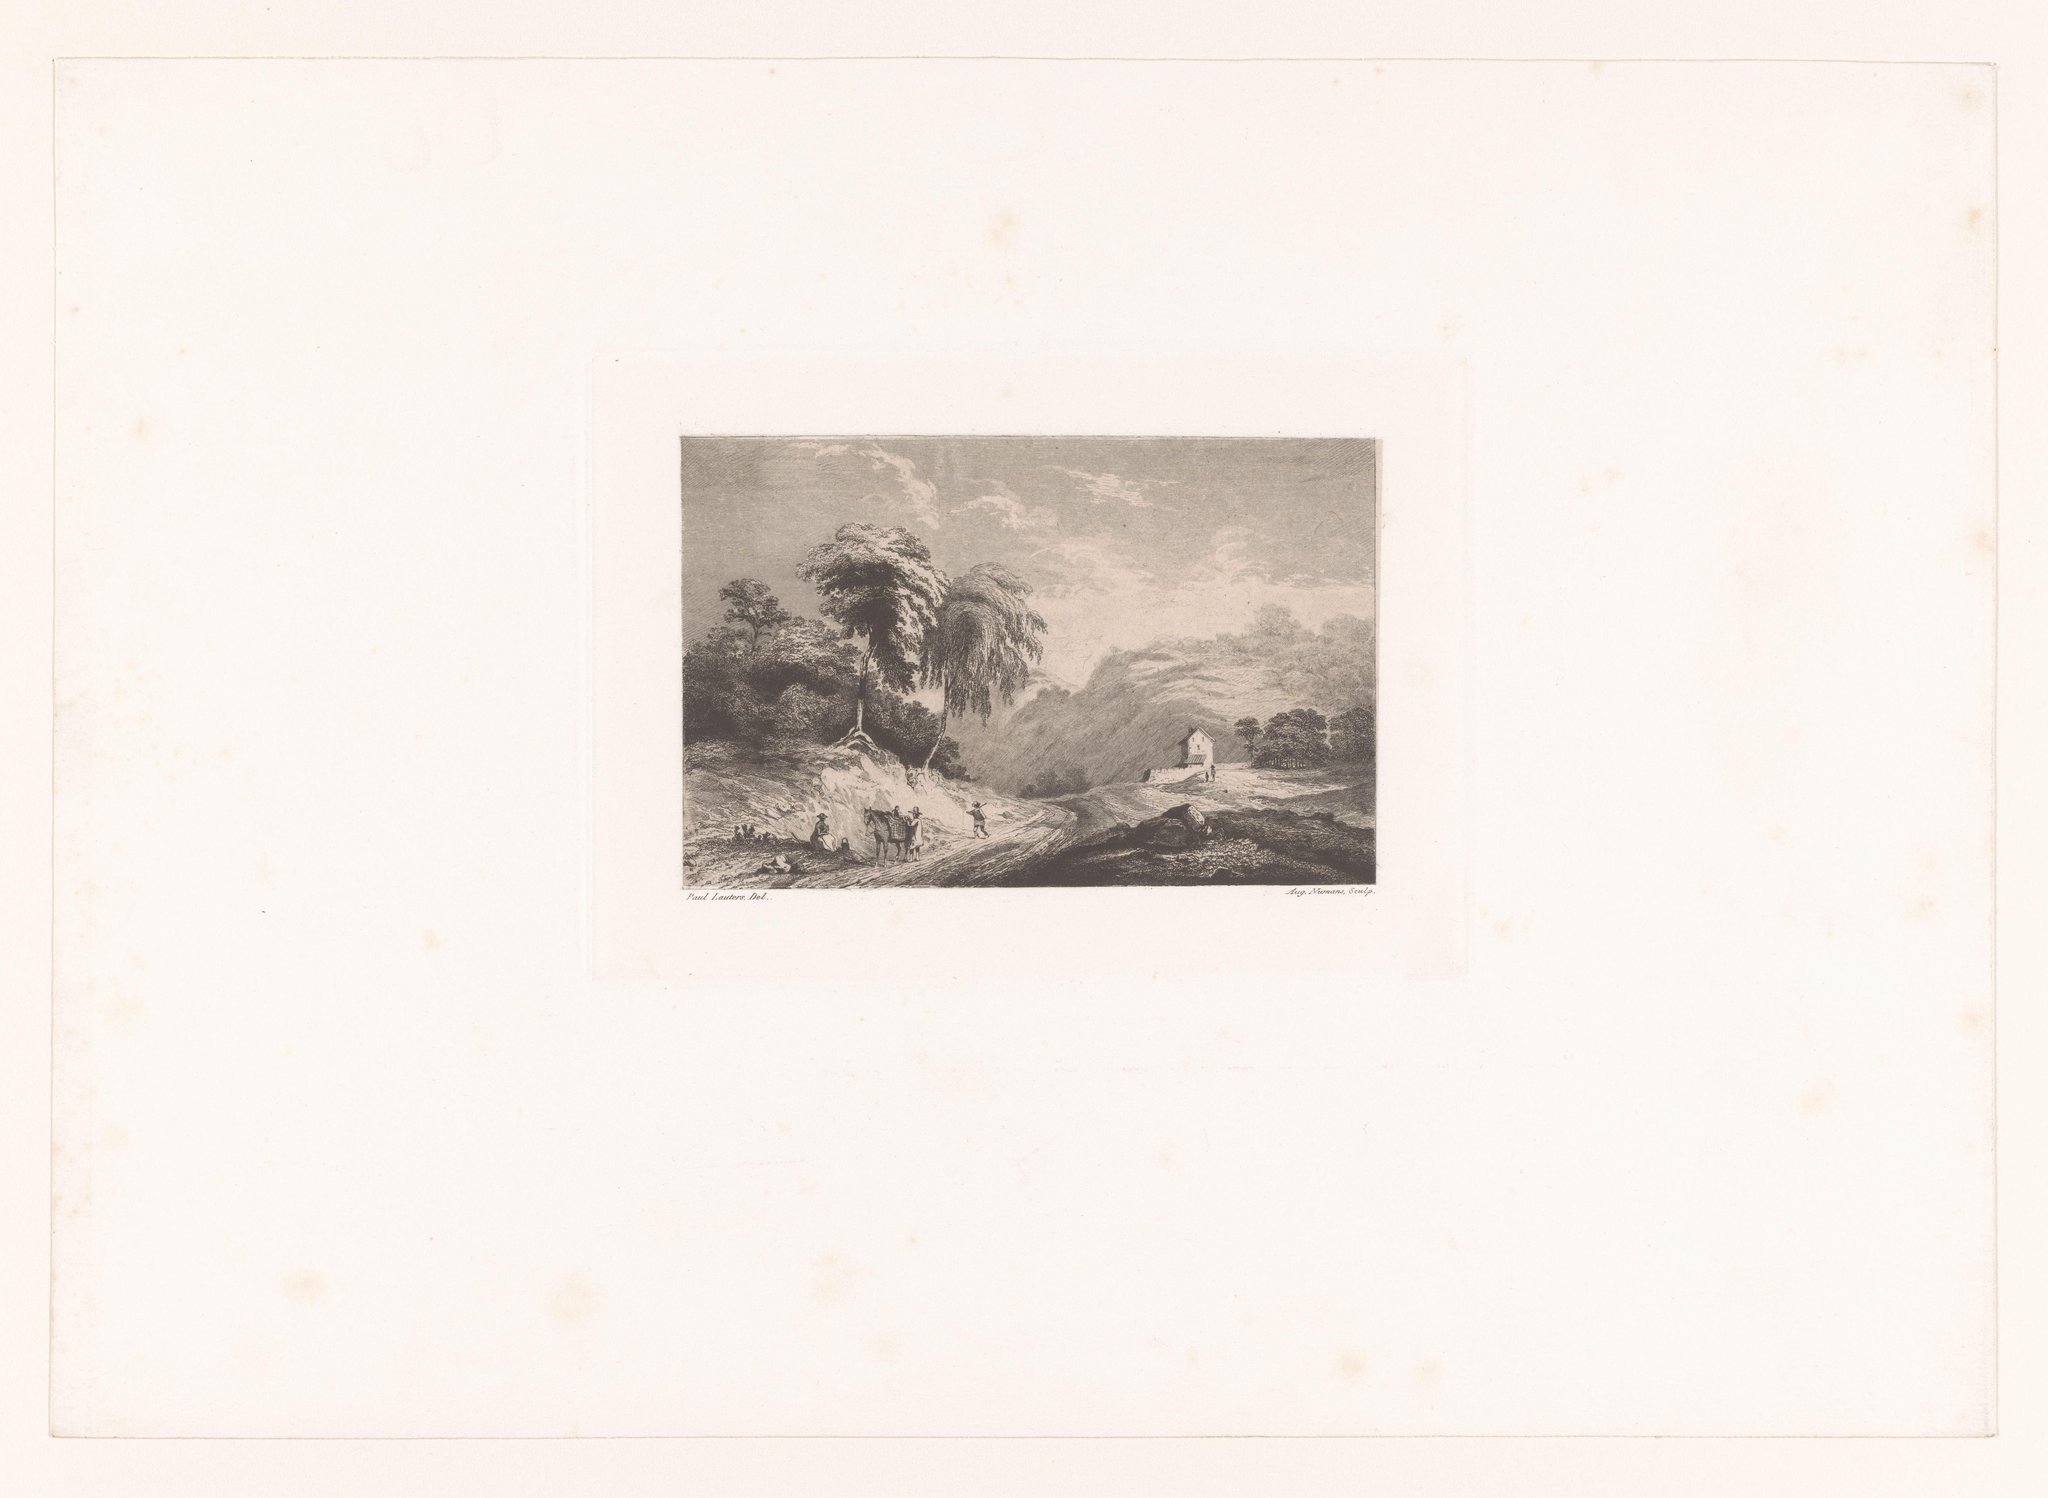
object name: print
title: Landschappen door Auguste Numans naar andere kunstenaars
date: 1833-1879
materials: paper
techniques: etching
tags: (traveller) resting in the open air, road, path, horse, (high) hill (+ landscape with figures, staffage)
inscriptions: collector's mark: Lugt 2228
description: Deze prent behoort tot een prentserie met diverse landschappen in prent gebracht door Auguste Numans naar voorbeelden van andere kunstenaars.